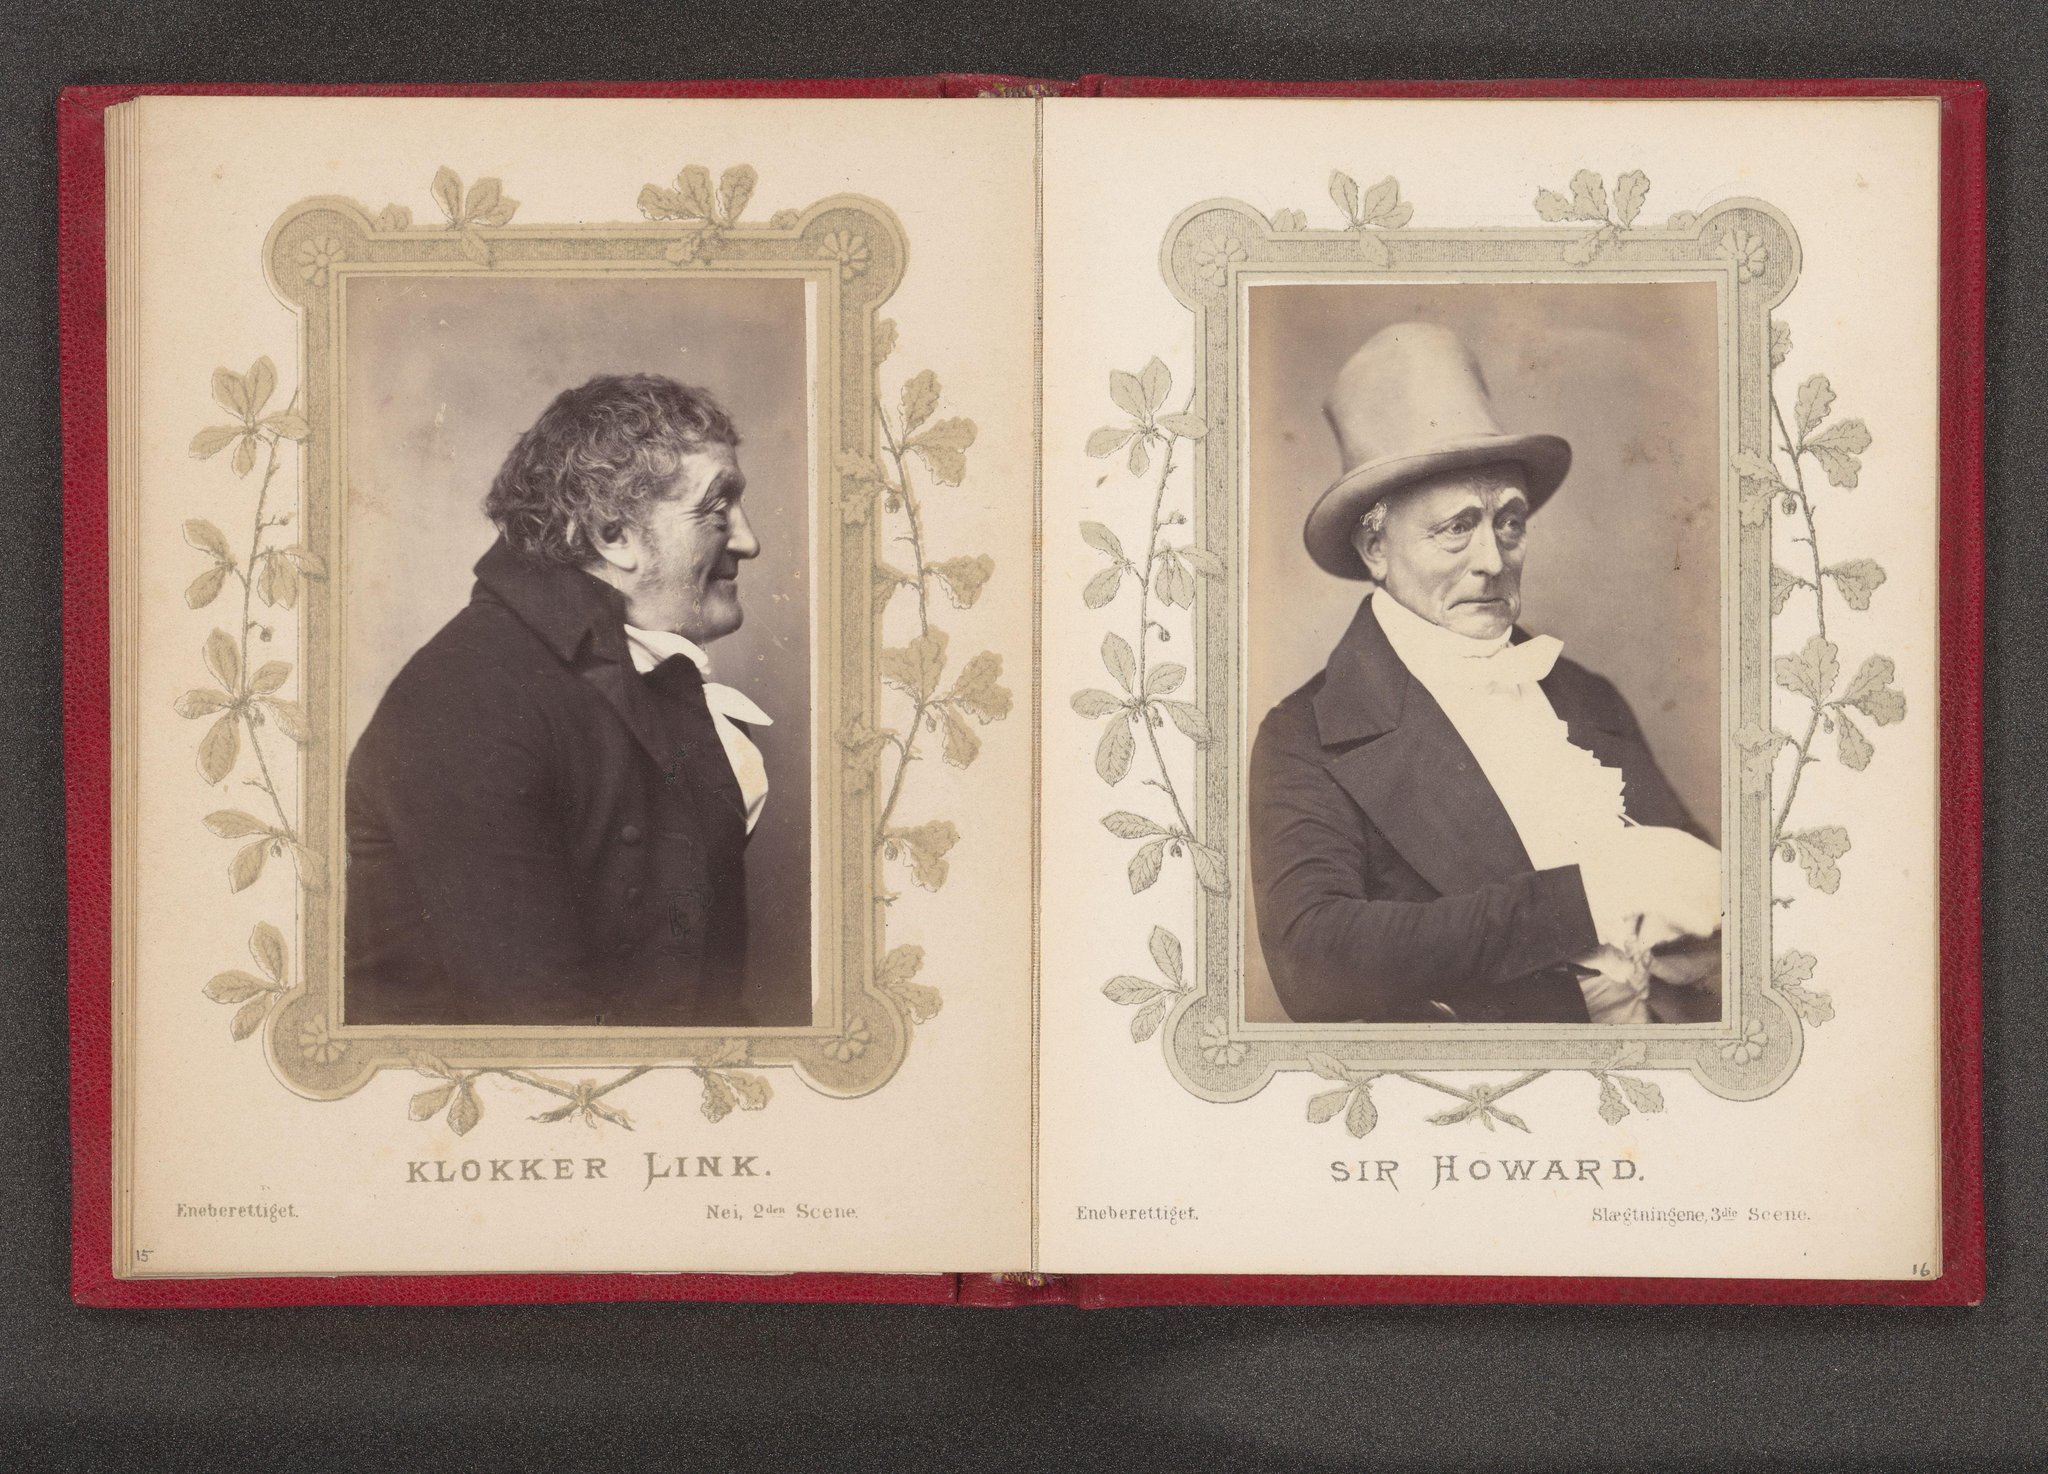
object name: photograph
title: Klokker Link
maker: harald paetz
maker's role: fotograaf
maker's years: 1837-1895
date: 1862-1872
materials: photographic support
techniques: albumen print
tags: stage costume, portrait of actor, actress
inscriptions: inscription: ‘Eneberettiget Nei, 2den Scene.’